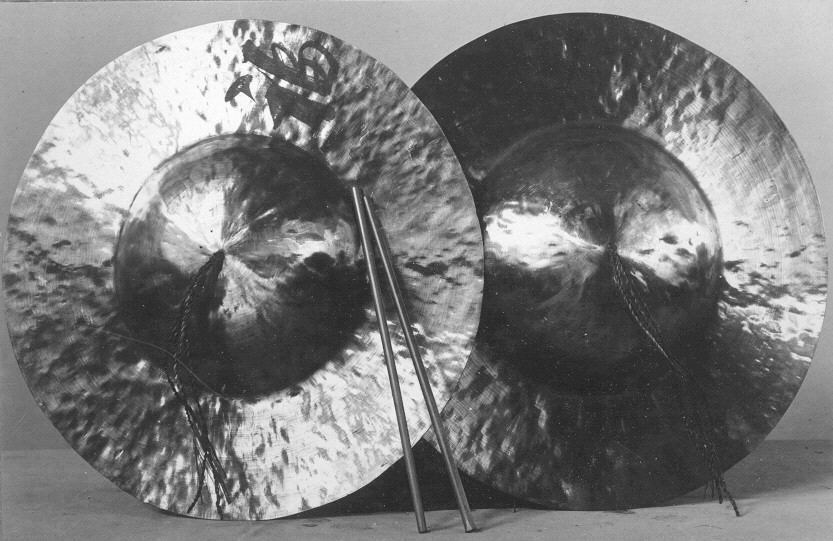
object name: po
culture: chinese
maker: chi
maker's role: maker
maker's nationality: chinese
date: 1801-1900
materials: bronze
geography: china